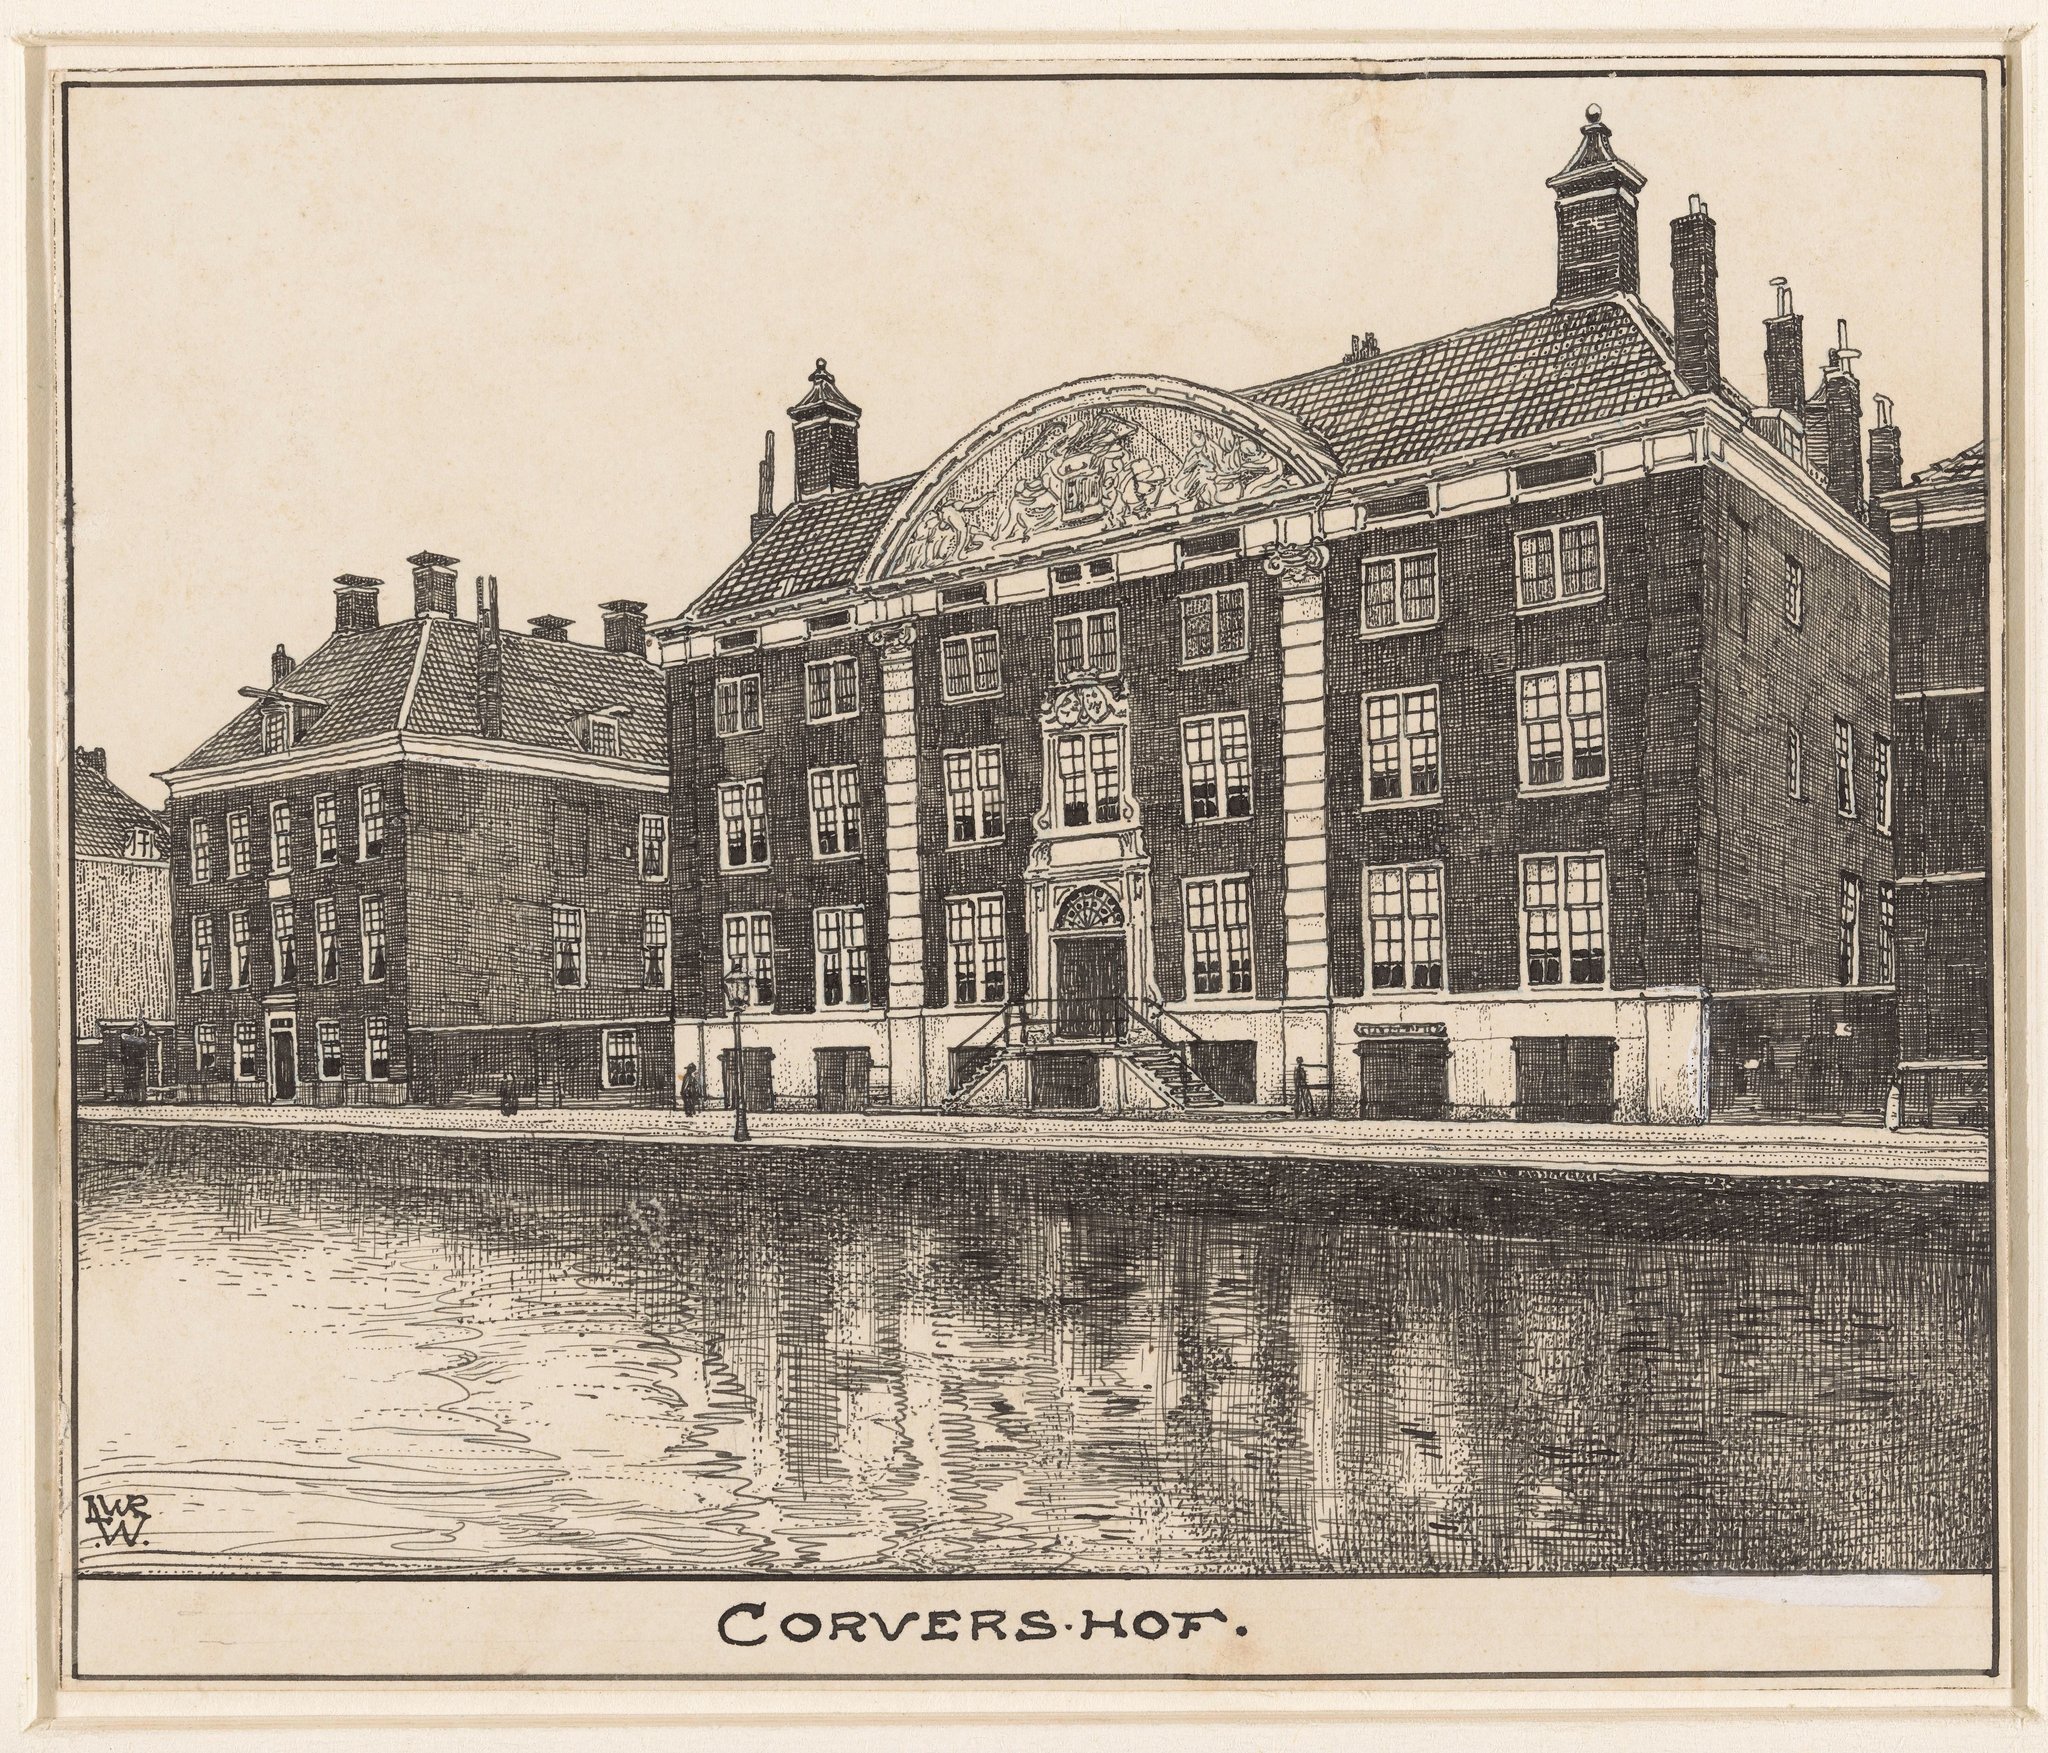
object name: drawing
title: Corvershof te Amsterdam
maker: willem wenckebach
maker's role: designer, draughtsman, painter, print maker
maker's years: 1860-1937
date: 1870-1926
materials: paint, ink, paper, pencil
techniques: pen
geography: amsterdam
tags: alms-house (dutch: 'hofje'), amsterdam